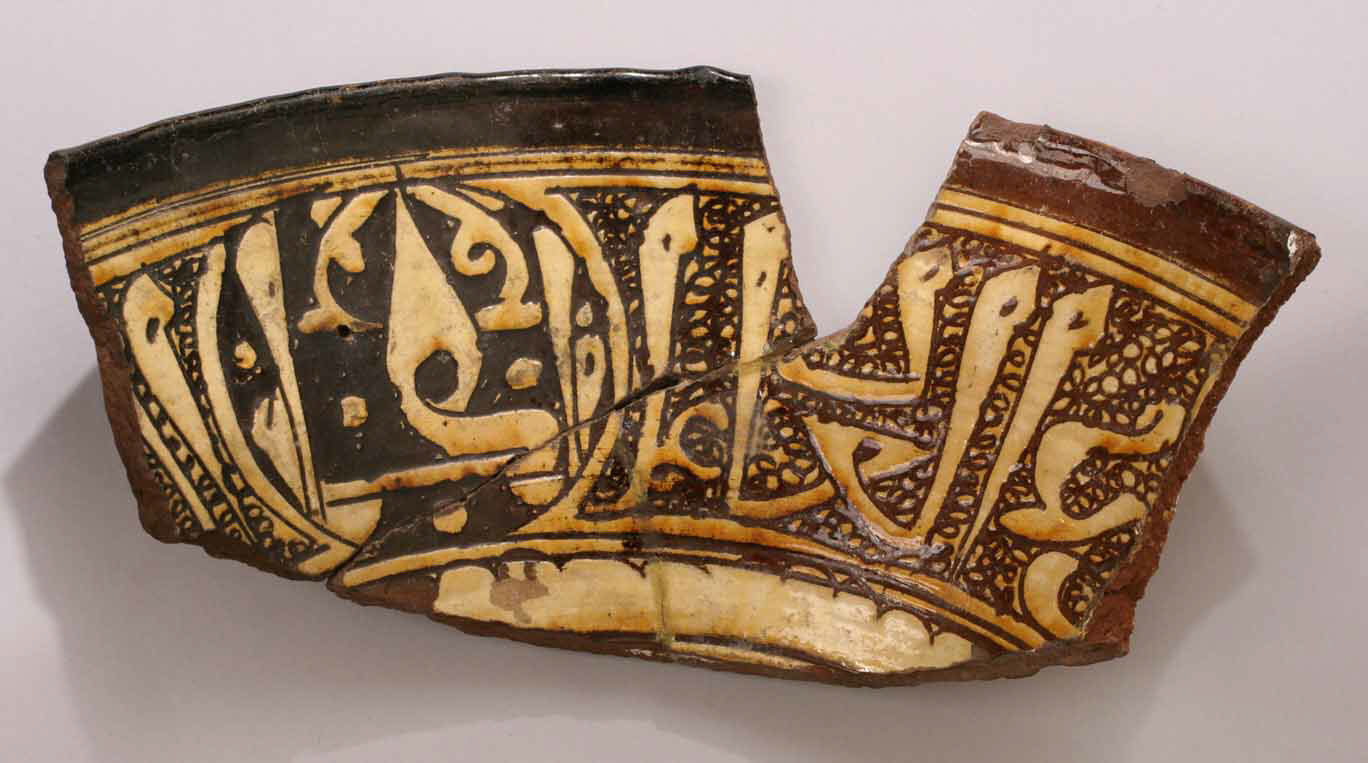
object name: fragment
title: Ceramic Fragment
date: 1301-1500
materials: earthenware, glaze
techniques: coloring, incising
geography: egypt